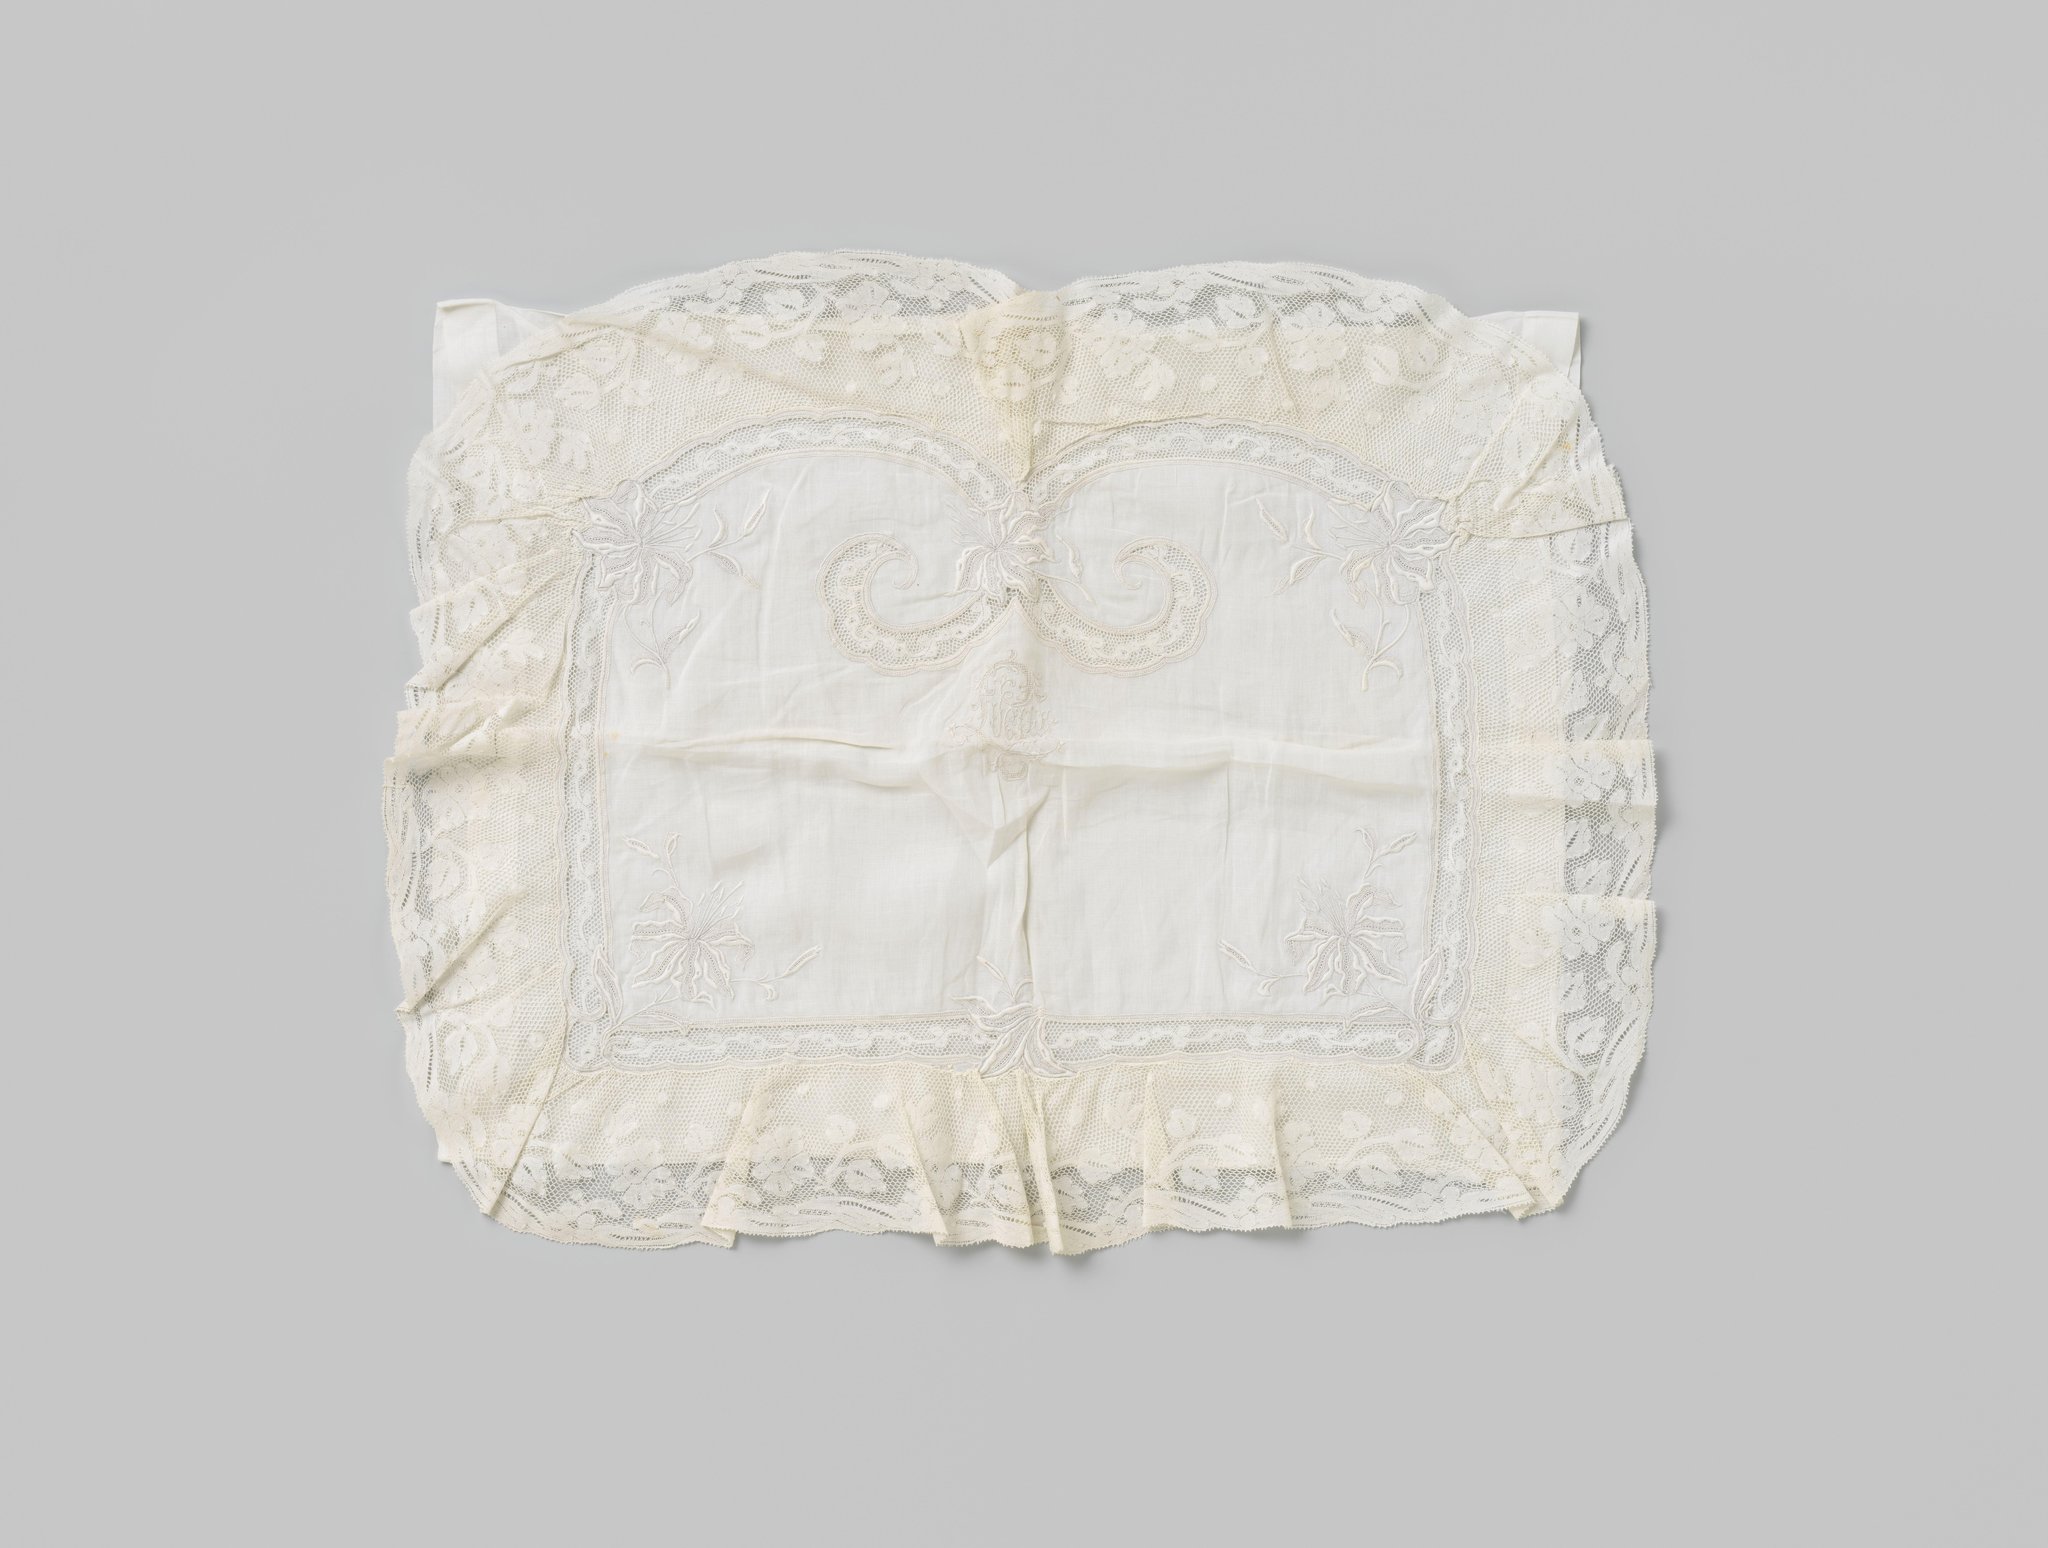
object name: bed covering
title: Sloop met wit borduurwerk met de naam Lucille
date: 1890-1910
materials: yarns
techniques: lace, embroidered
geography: netherlands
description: Sloop met wit borduurwerk met de naam Lucille. Met bijpassend laken en een tweede sloop (a,c).